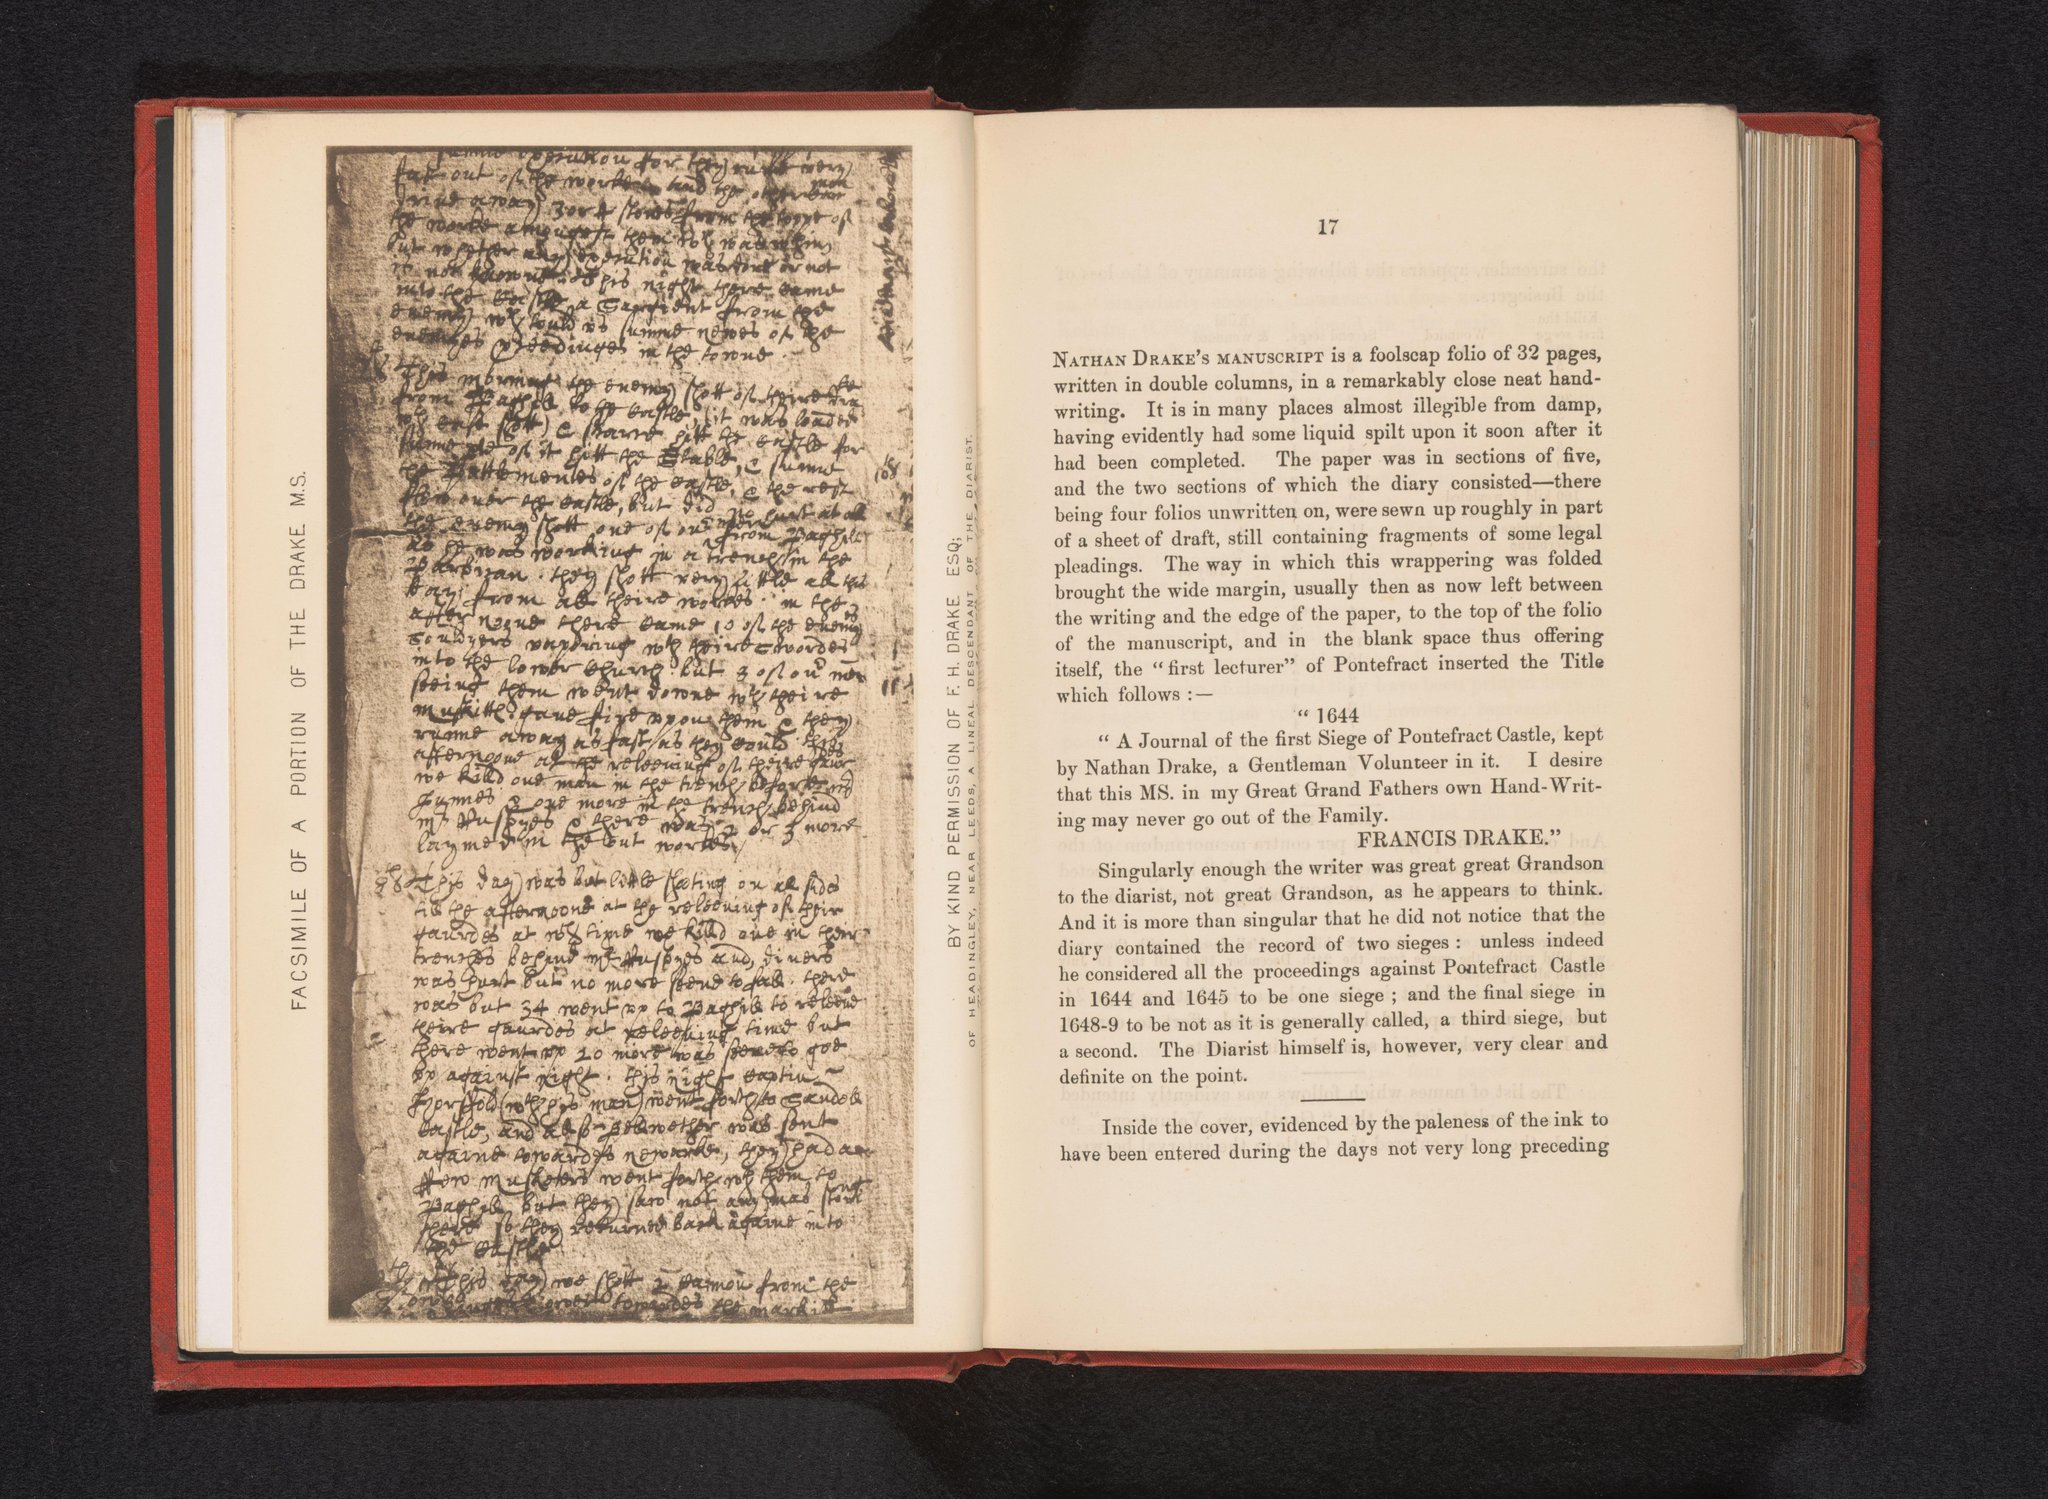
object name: photomechanical print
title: Reproductie van een pagina uit een manuscript van Nathan Drake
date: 1882-1887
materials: paper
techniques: photograph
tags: nathan drake (1587-1658), handwriting, written text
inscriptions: inscription: ‘By kind permission of F.H. Drake Esq;/ of Headingley, bear Leeds, a lineal descendant of the diarist./ The portion selected is under date May 7th & 8th 1645/ with fragments belonging to the entries of May 9th - 10th and 11th see p.p. 63-65.’